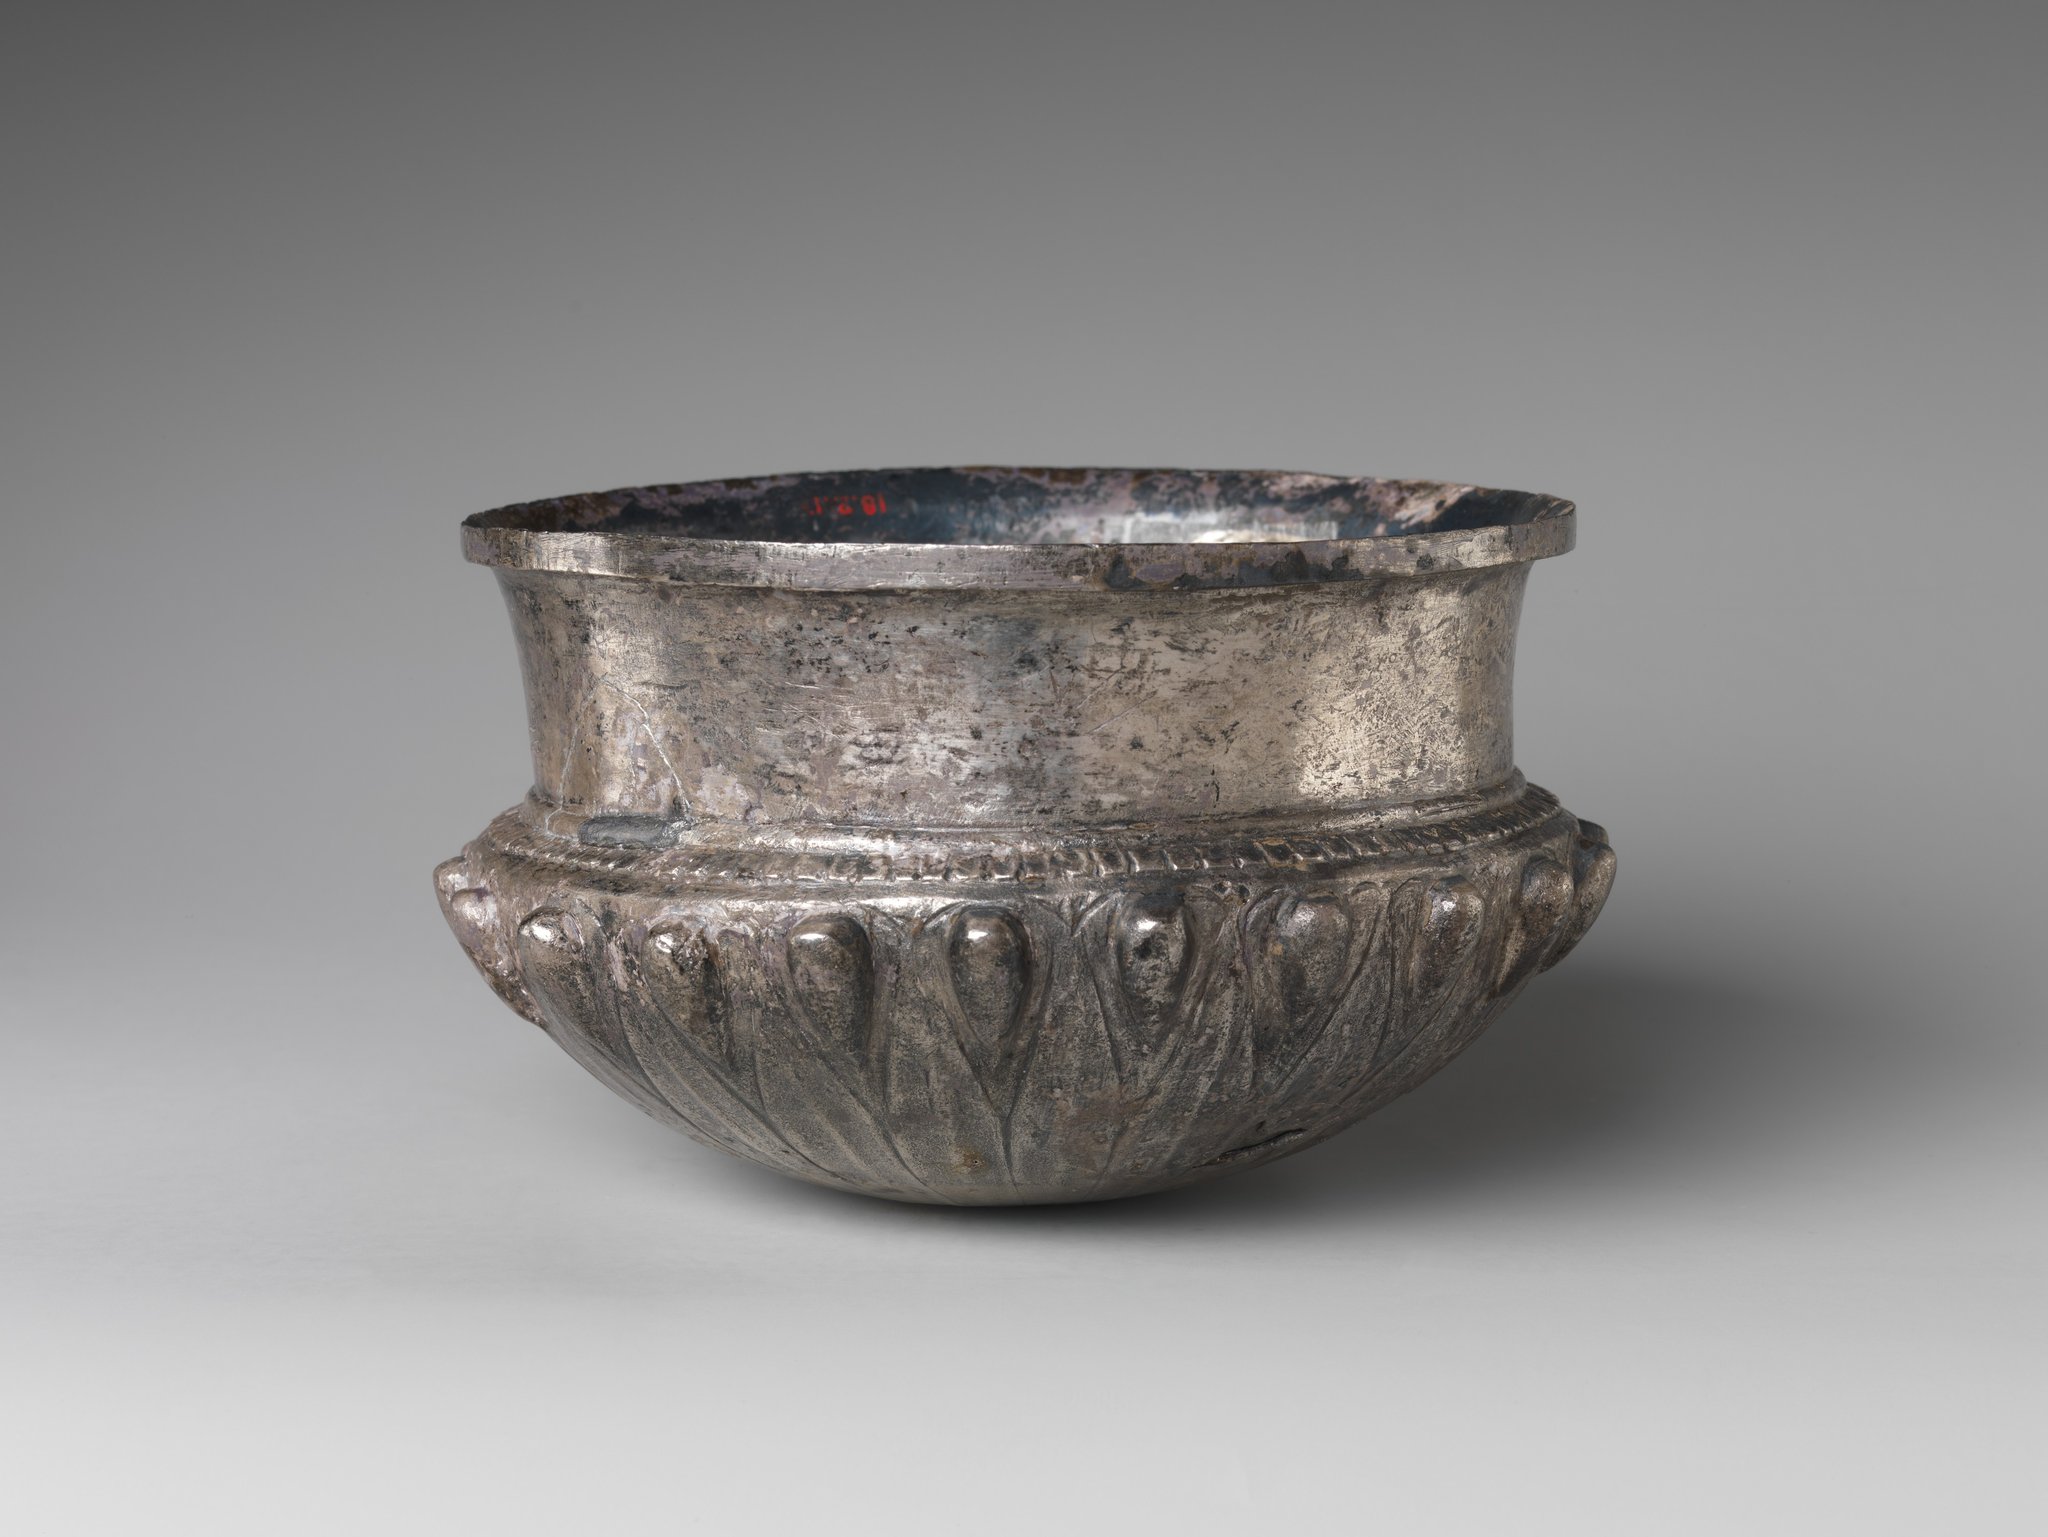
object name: bowl, boss, acorn, weight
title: Bowl with acorn bosses at shoulder, lotus pattern beneath, and rosette on bottom, and with inscribed weight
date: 400-301 BCE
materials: silver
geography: egypt